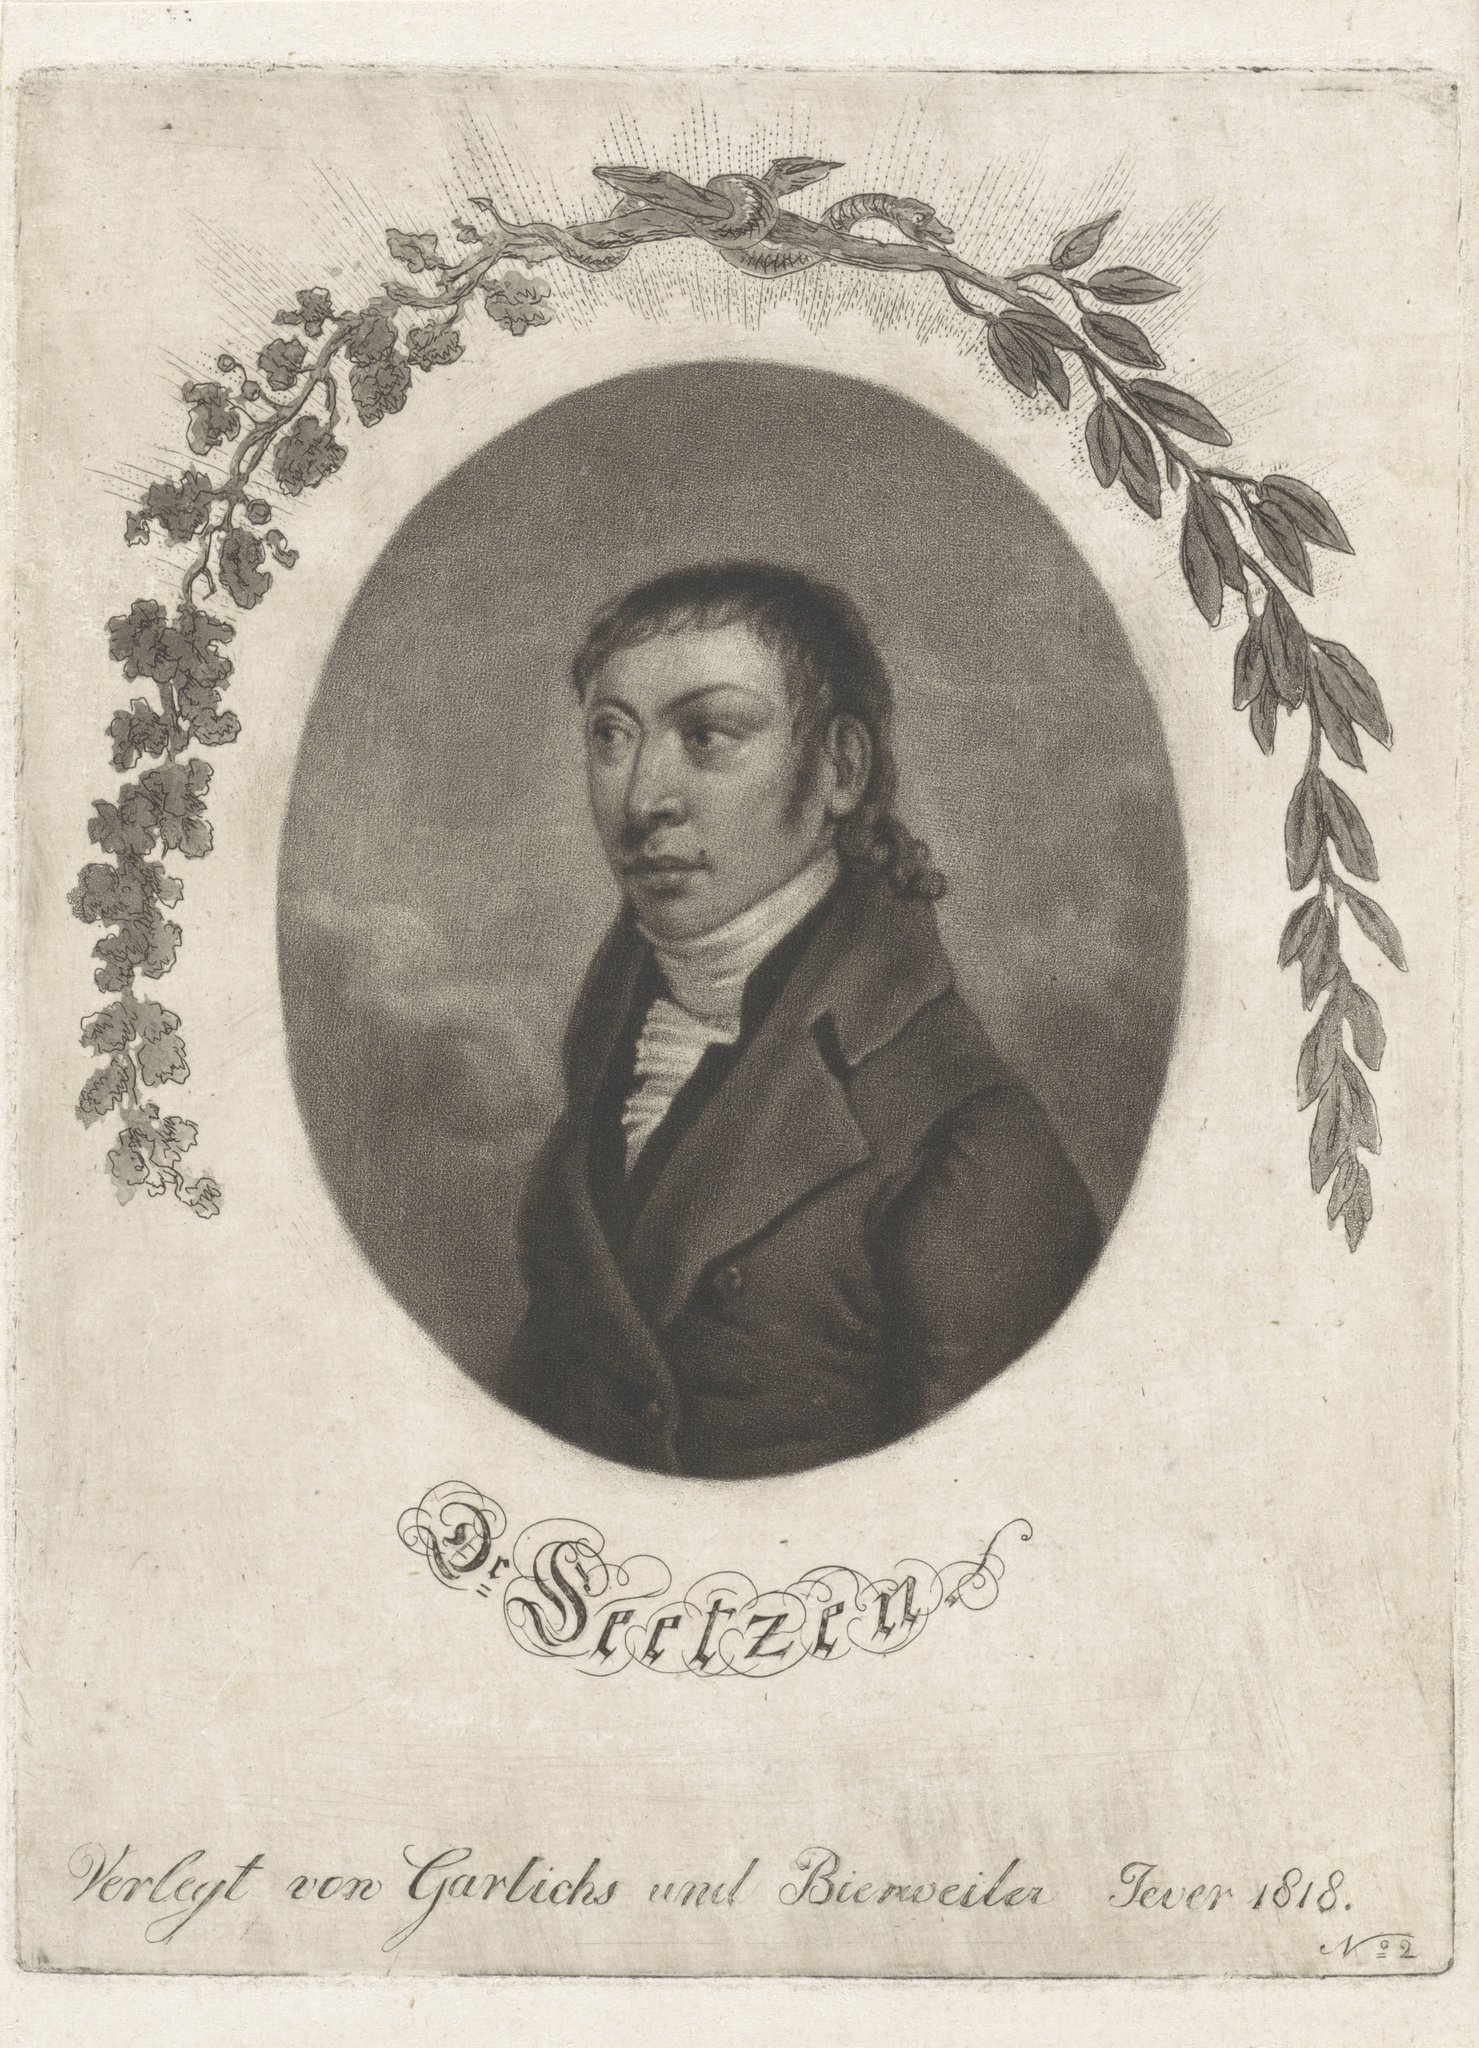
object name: print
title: Portret van Ulrich Jasper Seetzen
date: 1818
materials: paper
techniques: aquatint, etching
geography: jever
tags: snakes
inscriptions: collector's mark: Lugt 2228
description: Portret van de arts Ulrich Jasper Seetzen. Het portret is gedeeltelijk omlijst door twee takken die door een slang bijeen gehouden worden.